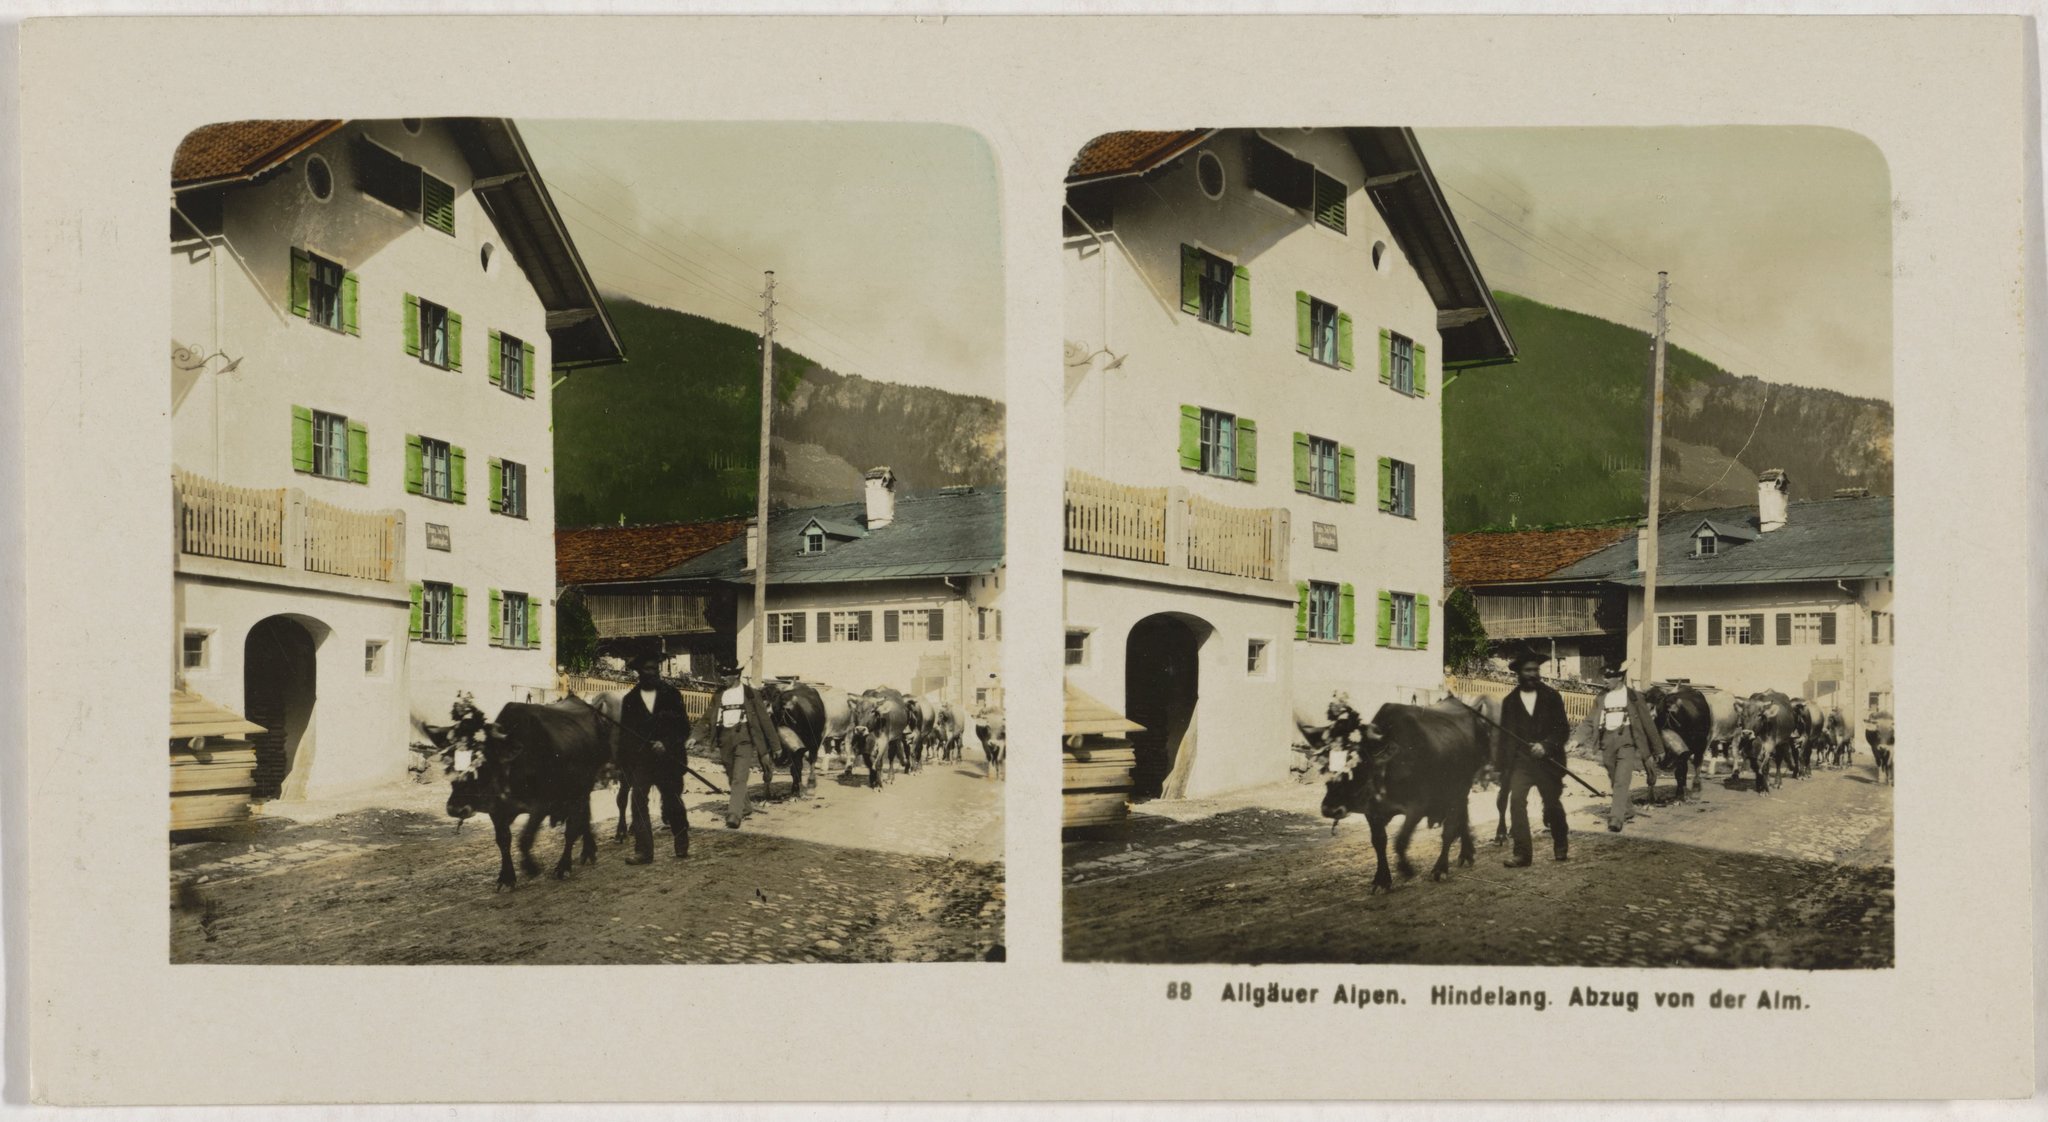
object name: stereograph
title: Boeren keren terug met hun vee naar het dal in de Allgäuer Alpen, Duitsland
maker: bw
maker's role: fotograaf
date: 1898-1935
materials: photographic support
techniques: gelatin silver print, hand coloring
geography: allgäuer alpen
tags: return to the fold, byre, stable ~ herd, herdsman, village, mountains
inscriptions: inscription: ‘Deutschland. Allgäuer Alpen. Hindelang. Abzug von der Alm./ Germany The Allgäuer-Alps. Hindelang. Departure from the/ mountains./ Allemagne. Les Alpes de l'Allgäu. Hindelang. Départ de l'Alpe. Alemania. Los Alpes del Allgäu. Hindelang. Partida de las/ montañas.’, number: ‘88’, monogram: ‘BW’